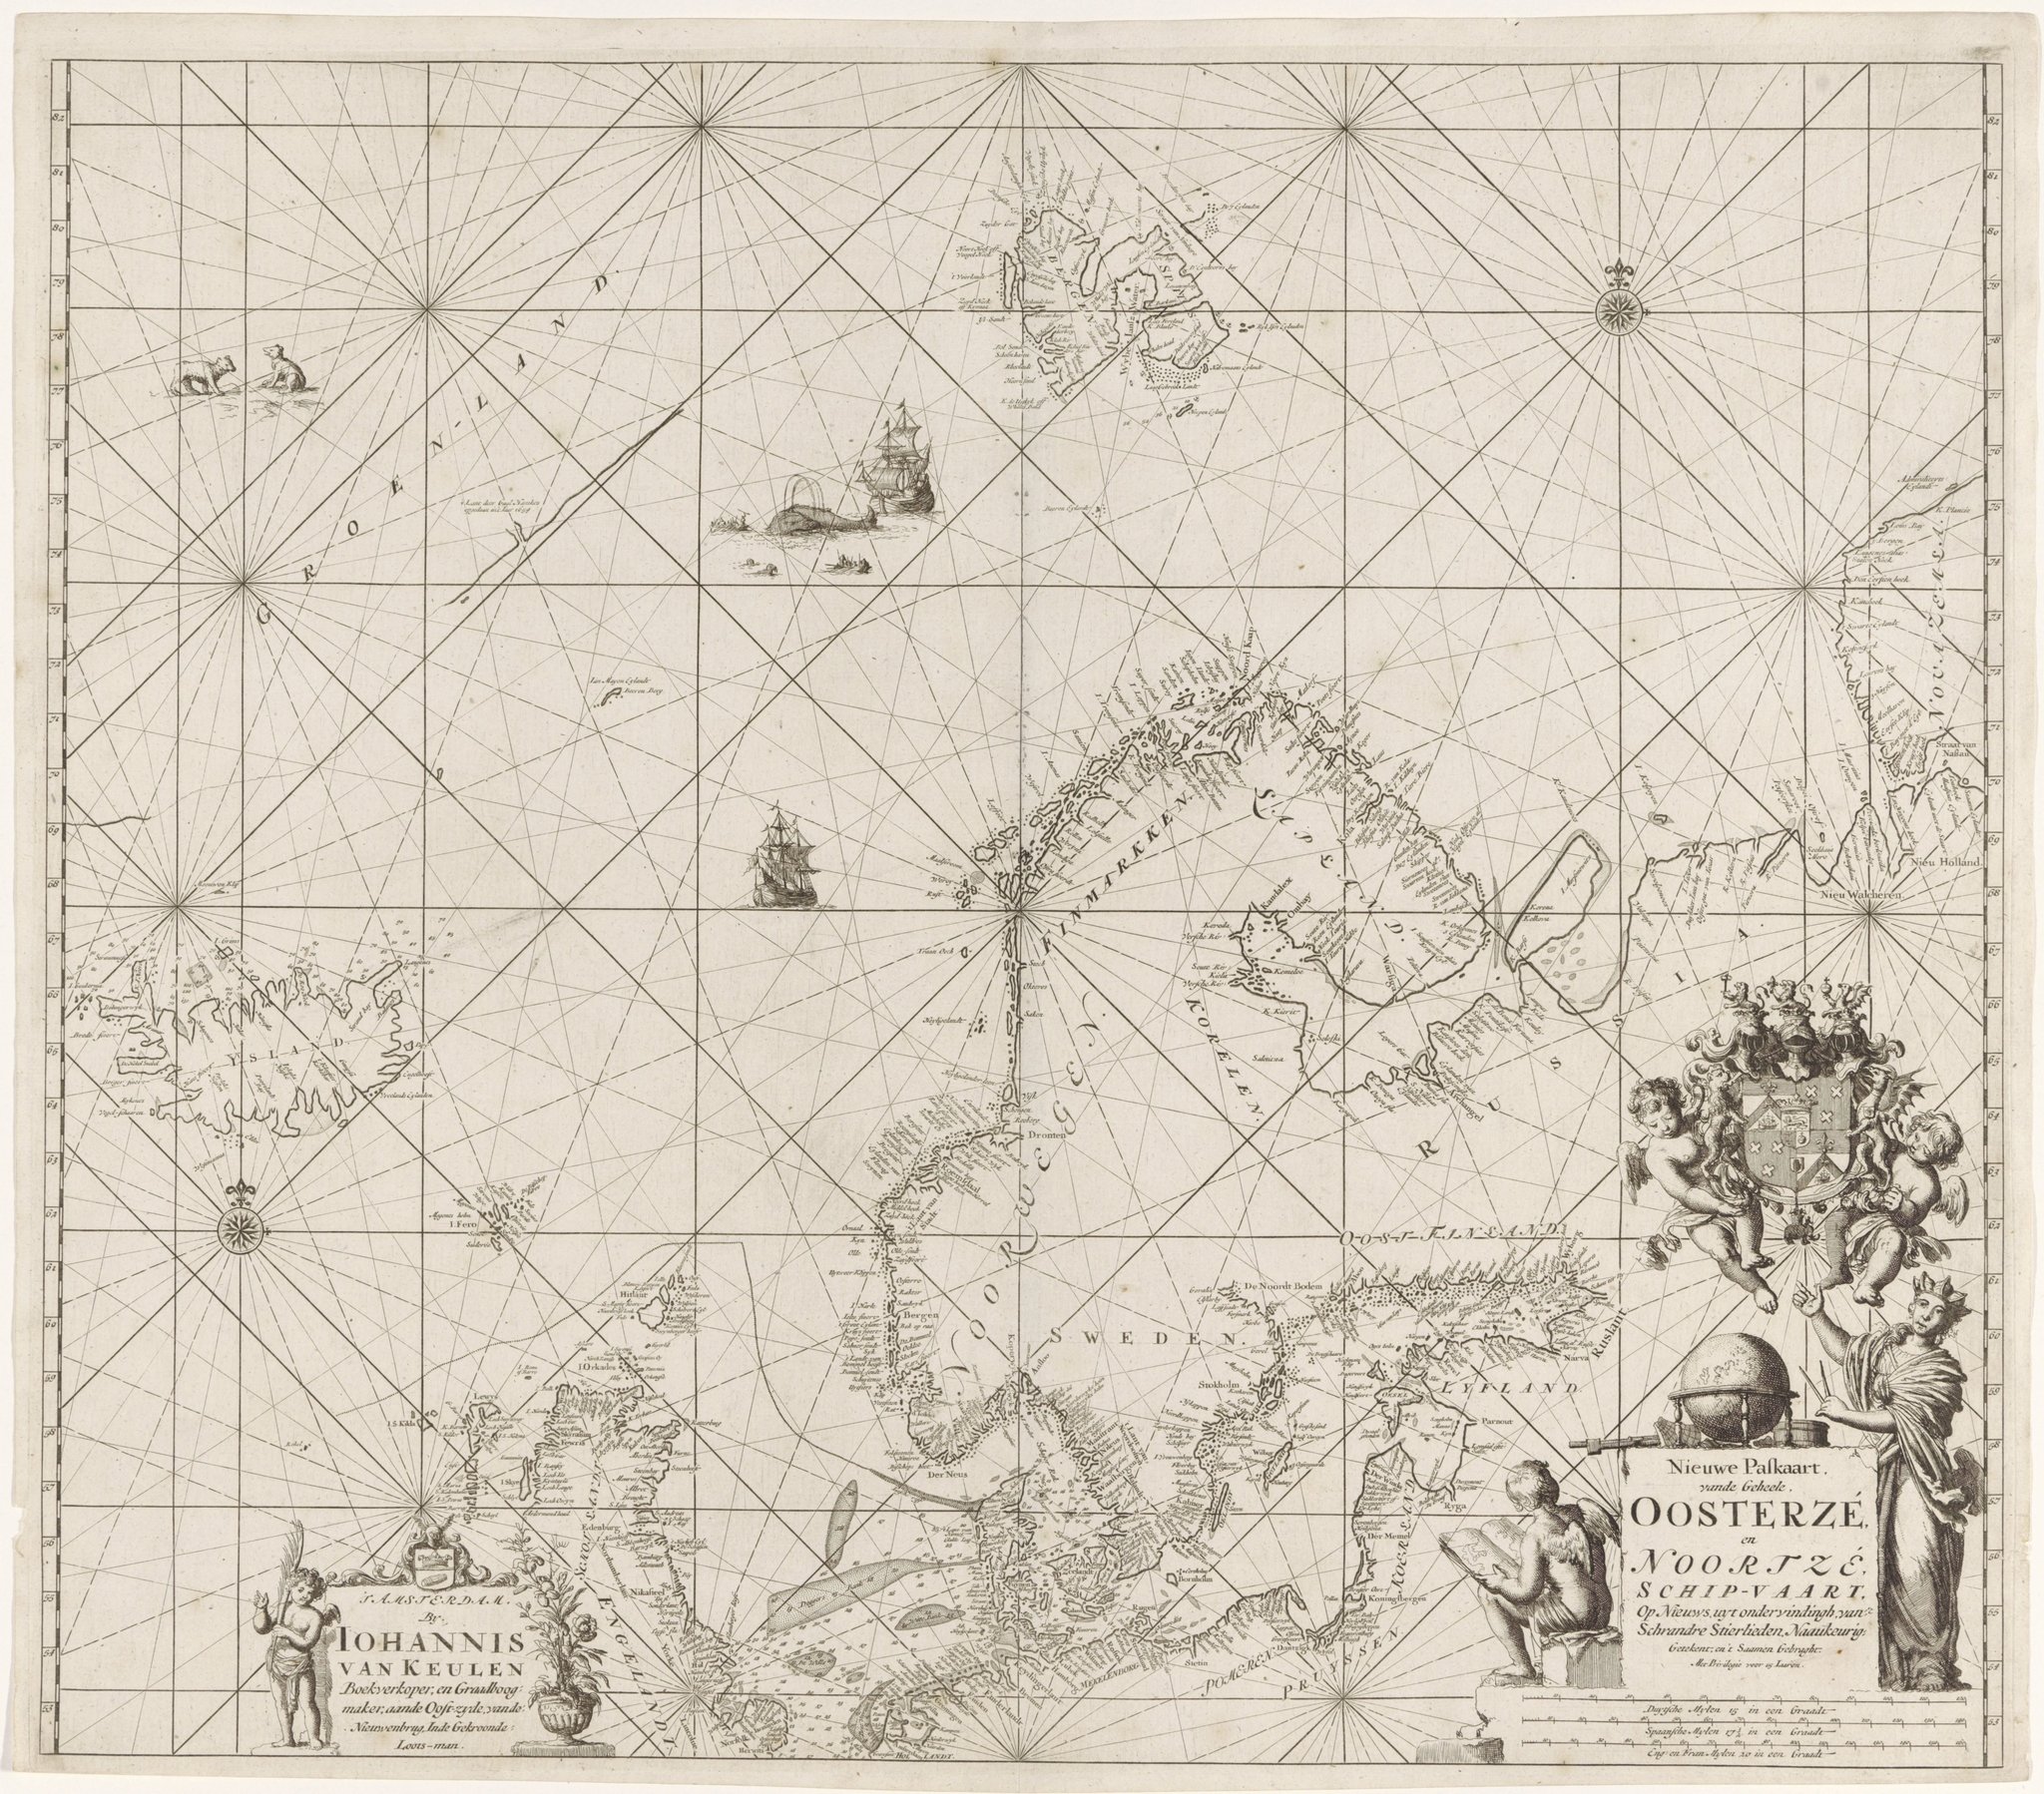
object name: print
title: Nieuwe Paskaart vande geheele Oosterzé en Noortzé, Schip-Vaart, Op Nieuws uyt ondervindingh van Schrandre Stierlieden Naaukeurig: Getekent, en 't Saamen gebraght.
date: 1681-1799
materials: paper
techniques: etching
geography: amsterdam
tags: maps, atlases, beasts of prey, predatory animals: bear, whale fishery, whaling, globe, cupids: 'amores', 'amoretti', 'putti', russia, england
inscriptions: collector's mark: Lugt 2228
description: Paskaart van de Oostzee en de Noordzee met twee kompasrozen, het Noorden ligt boven. Rechts een cartouche met de titel, waar onder de schaal in Duitse, Spaanse en Engelse of Franse mijlen. Links van de titel bekijkt een engel een atlas en rechts staat een vrouw met een schepenkroon en een passer bij een globe. Boven dit tafereel vliegen twee engeltjes met het wapen van Cornelis Tromp. Links het uitgeversadres geflankeerd door een engel met een palmtak en een vaas met bloemen. Linksboven twee ijsberen en lieden op schepen die op een walvis jagen.